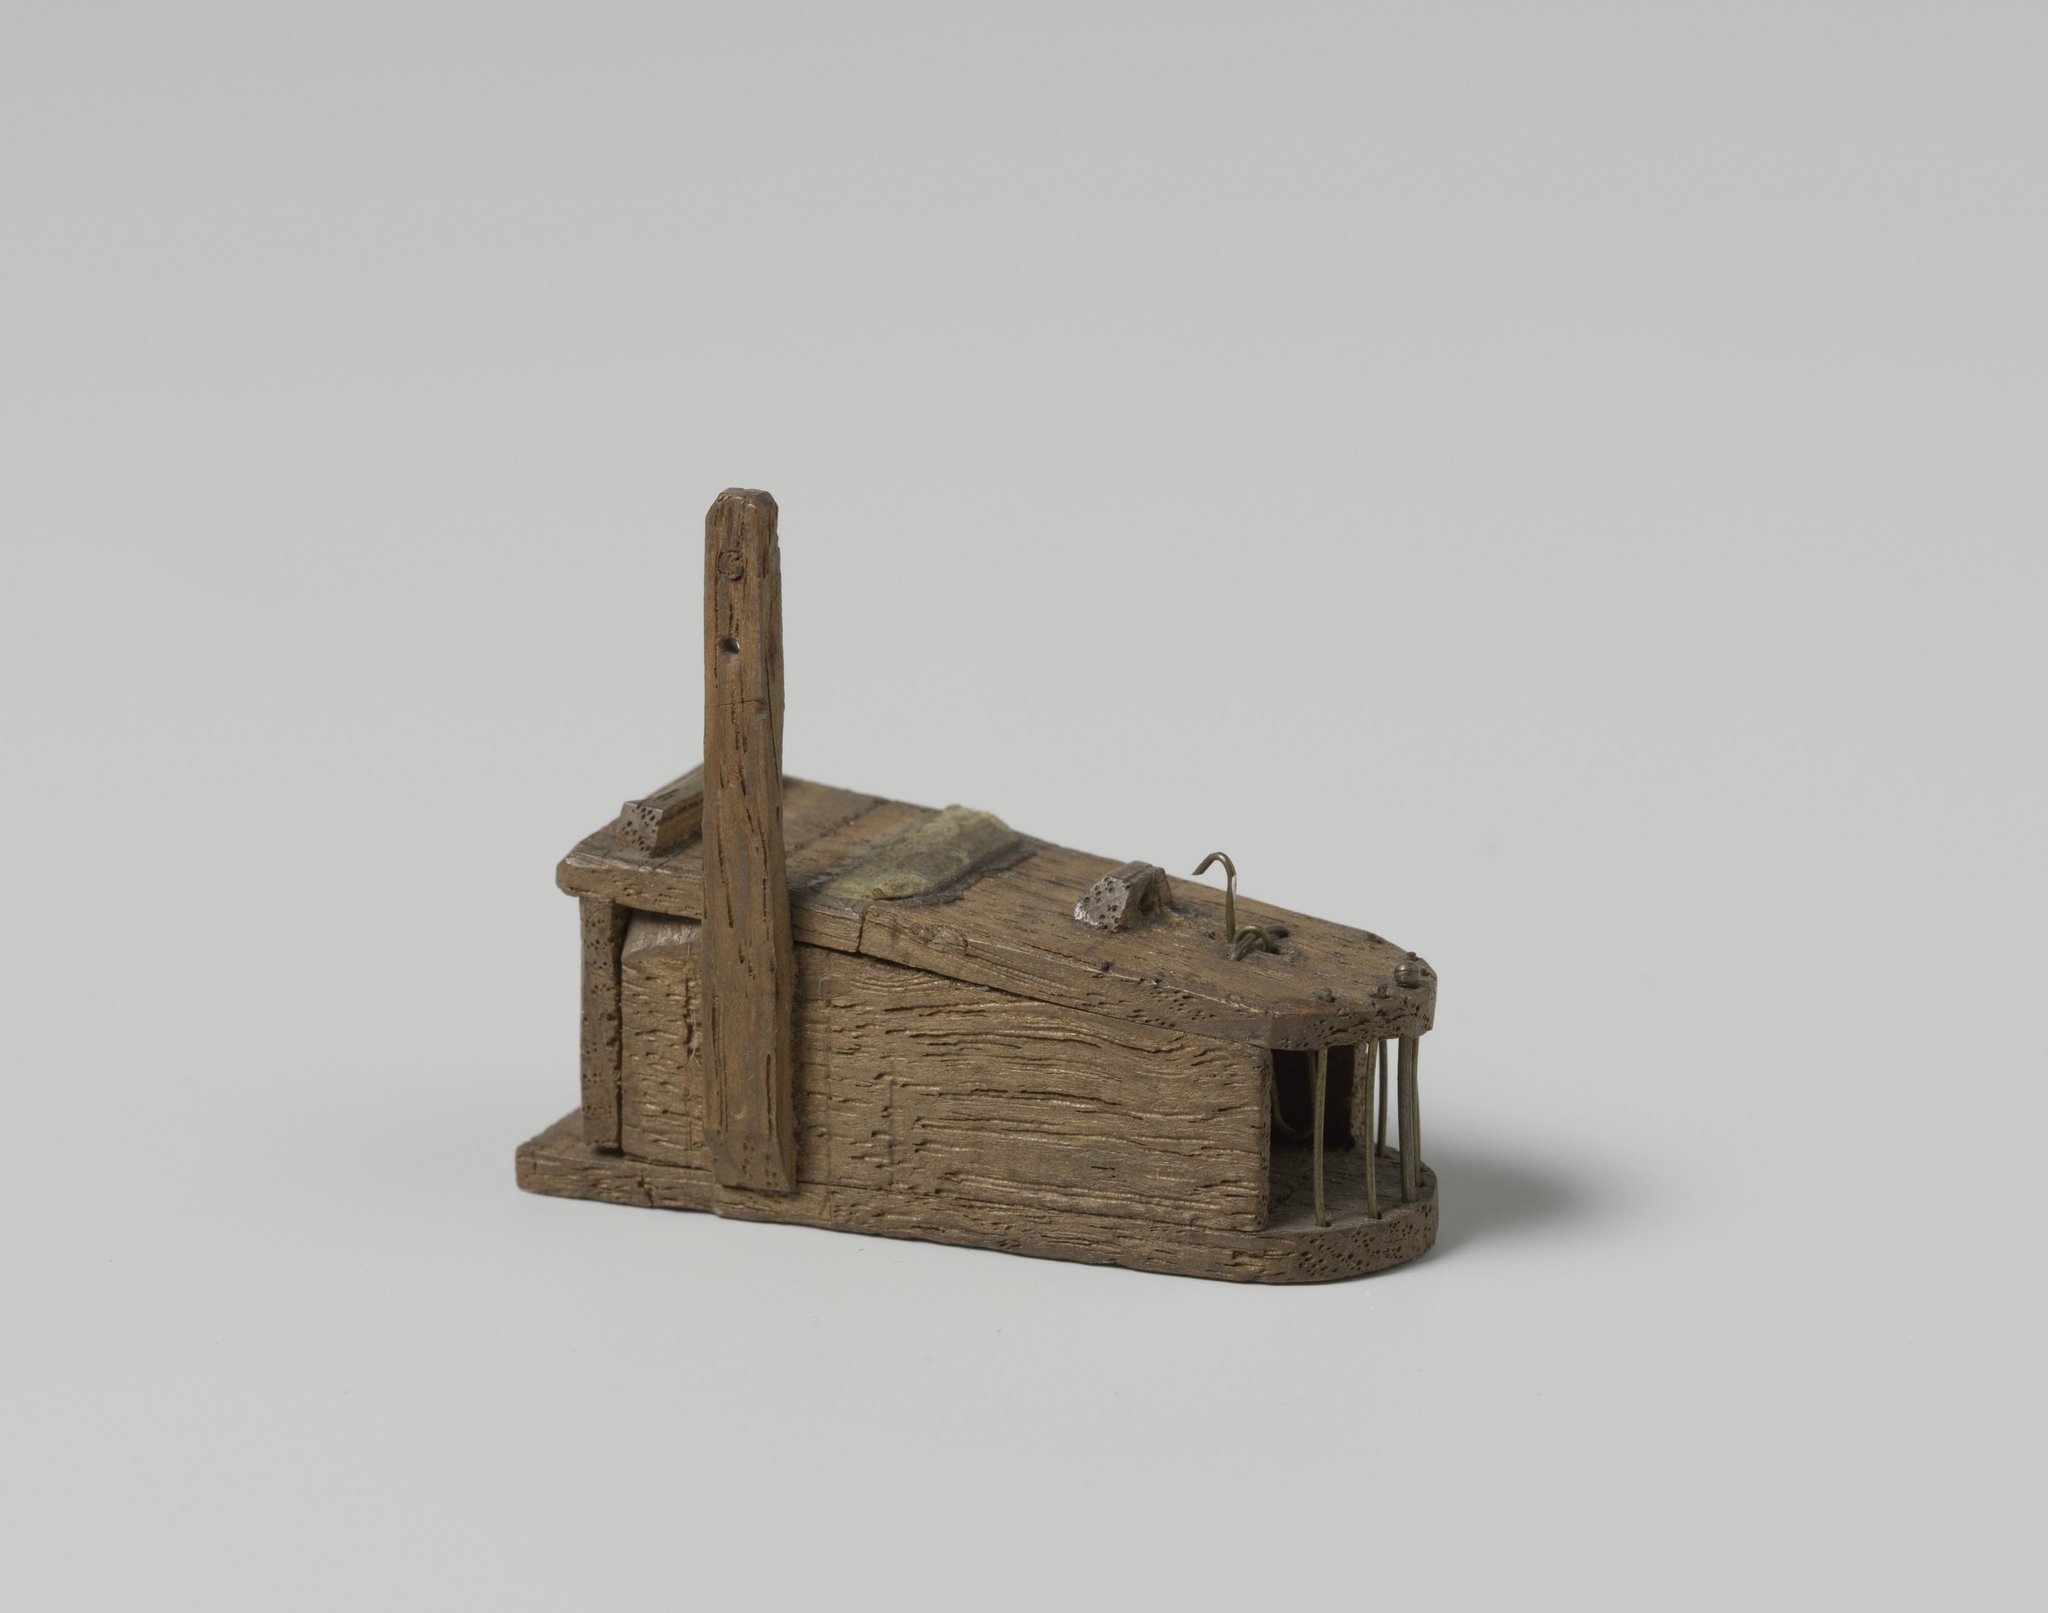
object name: rattenklem, rattenval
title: Rattenval met aan de halfronde korte zijde spijlen, de tegenoverliggende zijde met valdeur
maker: Anonymous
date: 1700-1799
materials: leather, wood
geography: amsterdam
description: Een rattenval van eikenhout met opklapdeur; leren scharnier, spijlen en haken van koperdraad. Valdeur-constructie ontbreekt grotendeels.